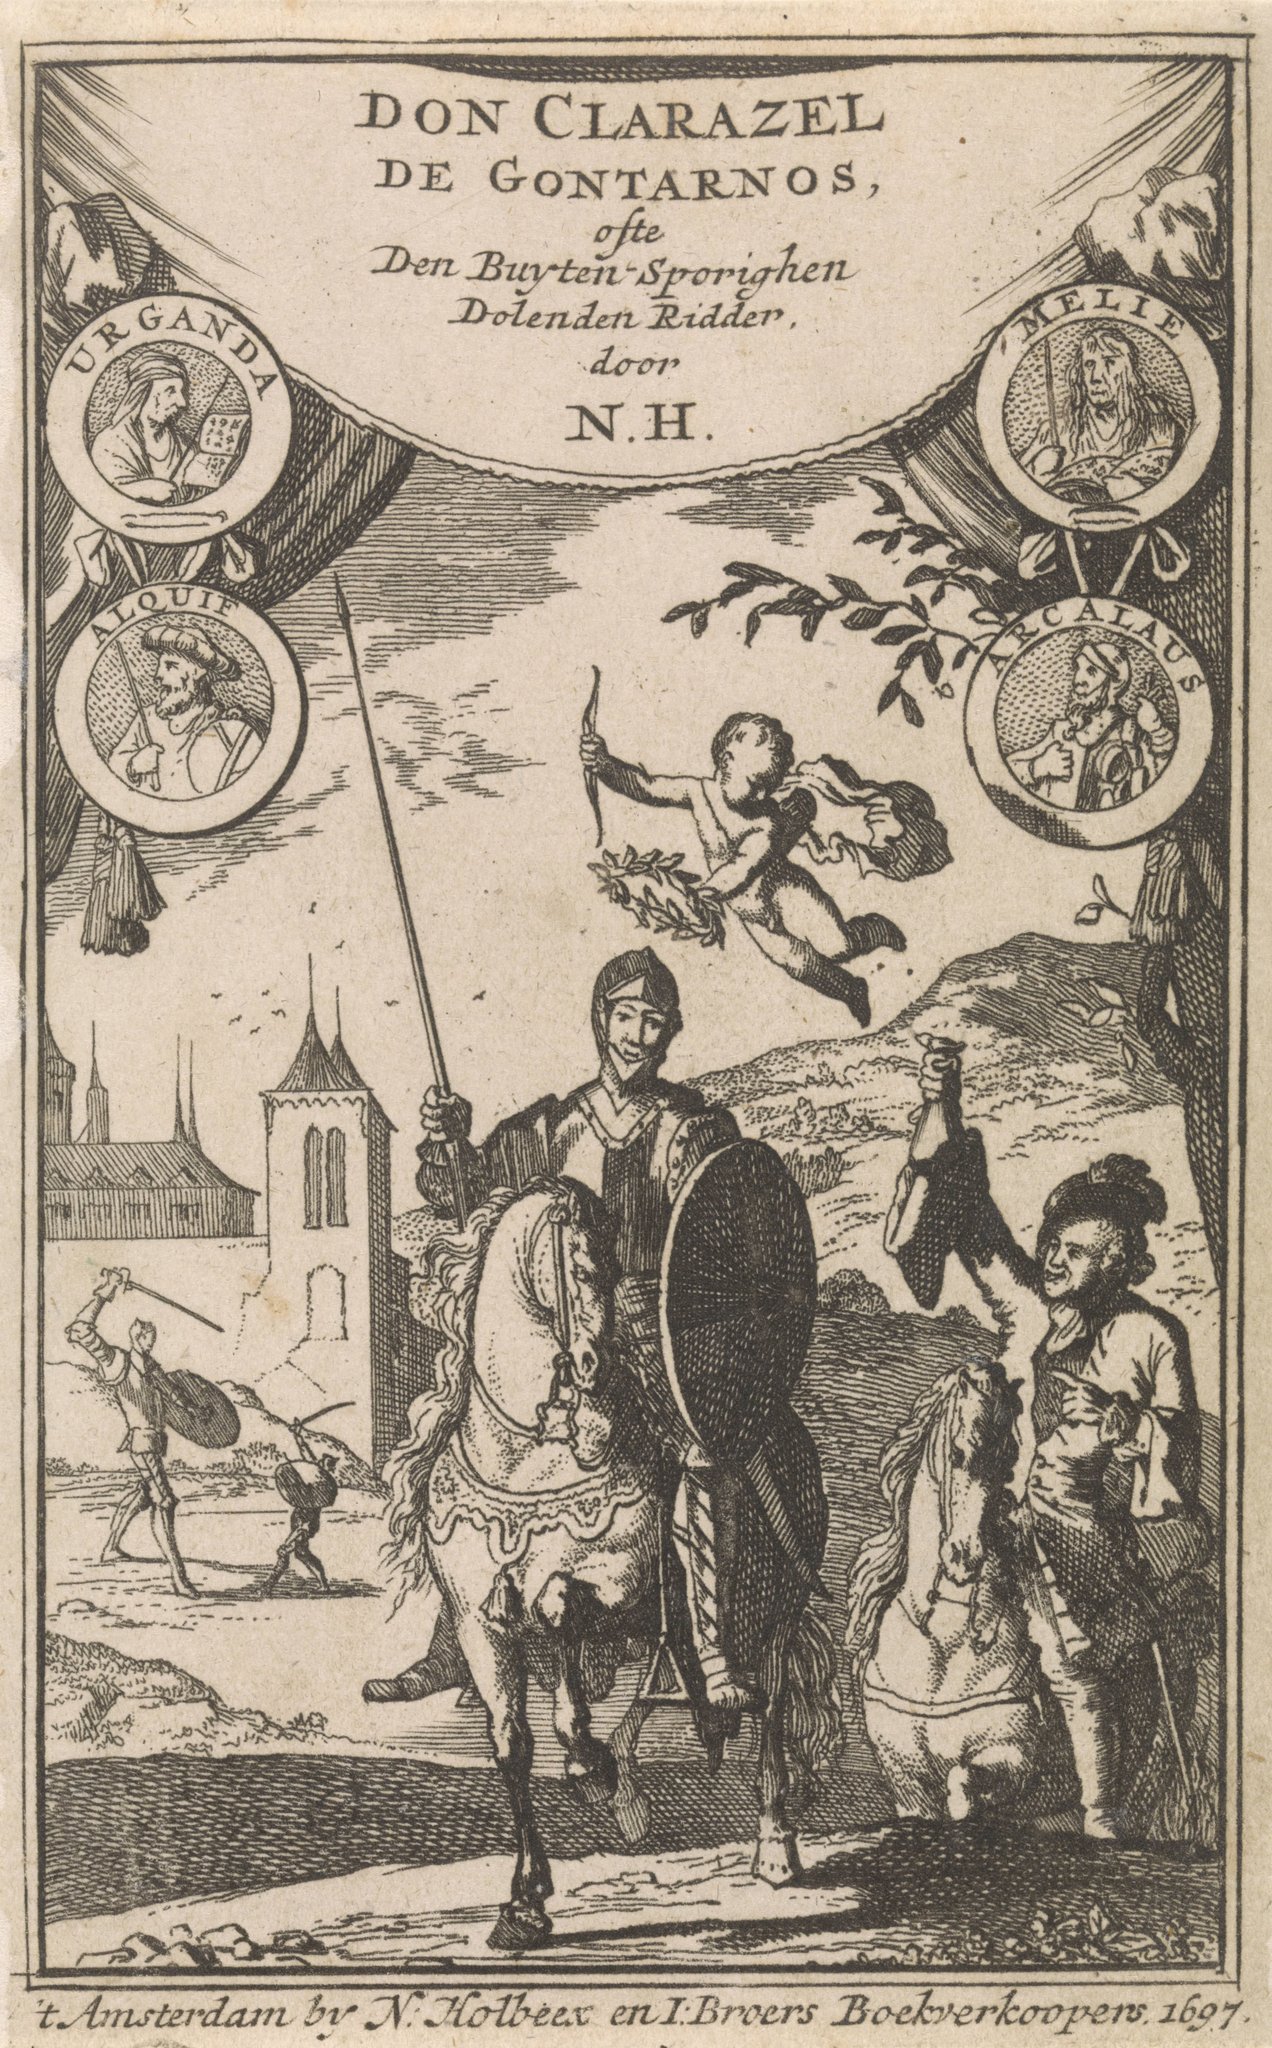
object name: titelblad, titelpagina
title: Titelpagina voor: G.S. du Verdier, Don Clarazel de Gontarnos, ofte den buiten-spoorigen dolenden ridder, 1697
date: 1697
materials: paper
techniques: etching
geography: amsterdam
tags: riding a horse, ass, or mule; rider, horseman, knight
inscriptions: collector's mark: Lugt 2228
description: Titelpagina voor: Verdier, Gilbert Saulnier du (vert. Heinsius, Nicolaas junior). Don Clarazel de Gontarnos, ofte den buiten-spoorigen dolenden ridder, 2 delen. Amsterdam: Johannes Broersz en Nathanael Holbeex, 1697.